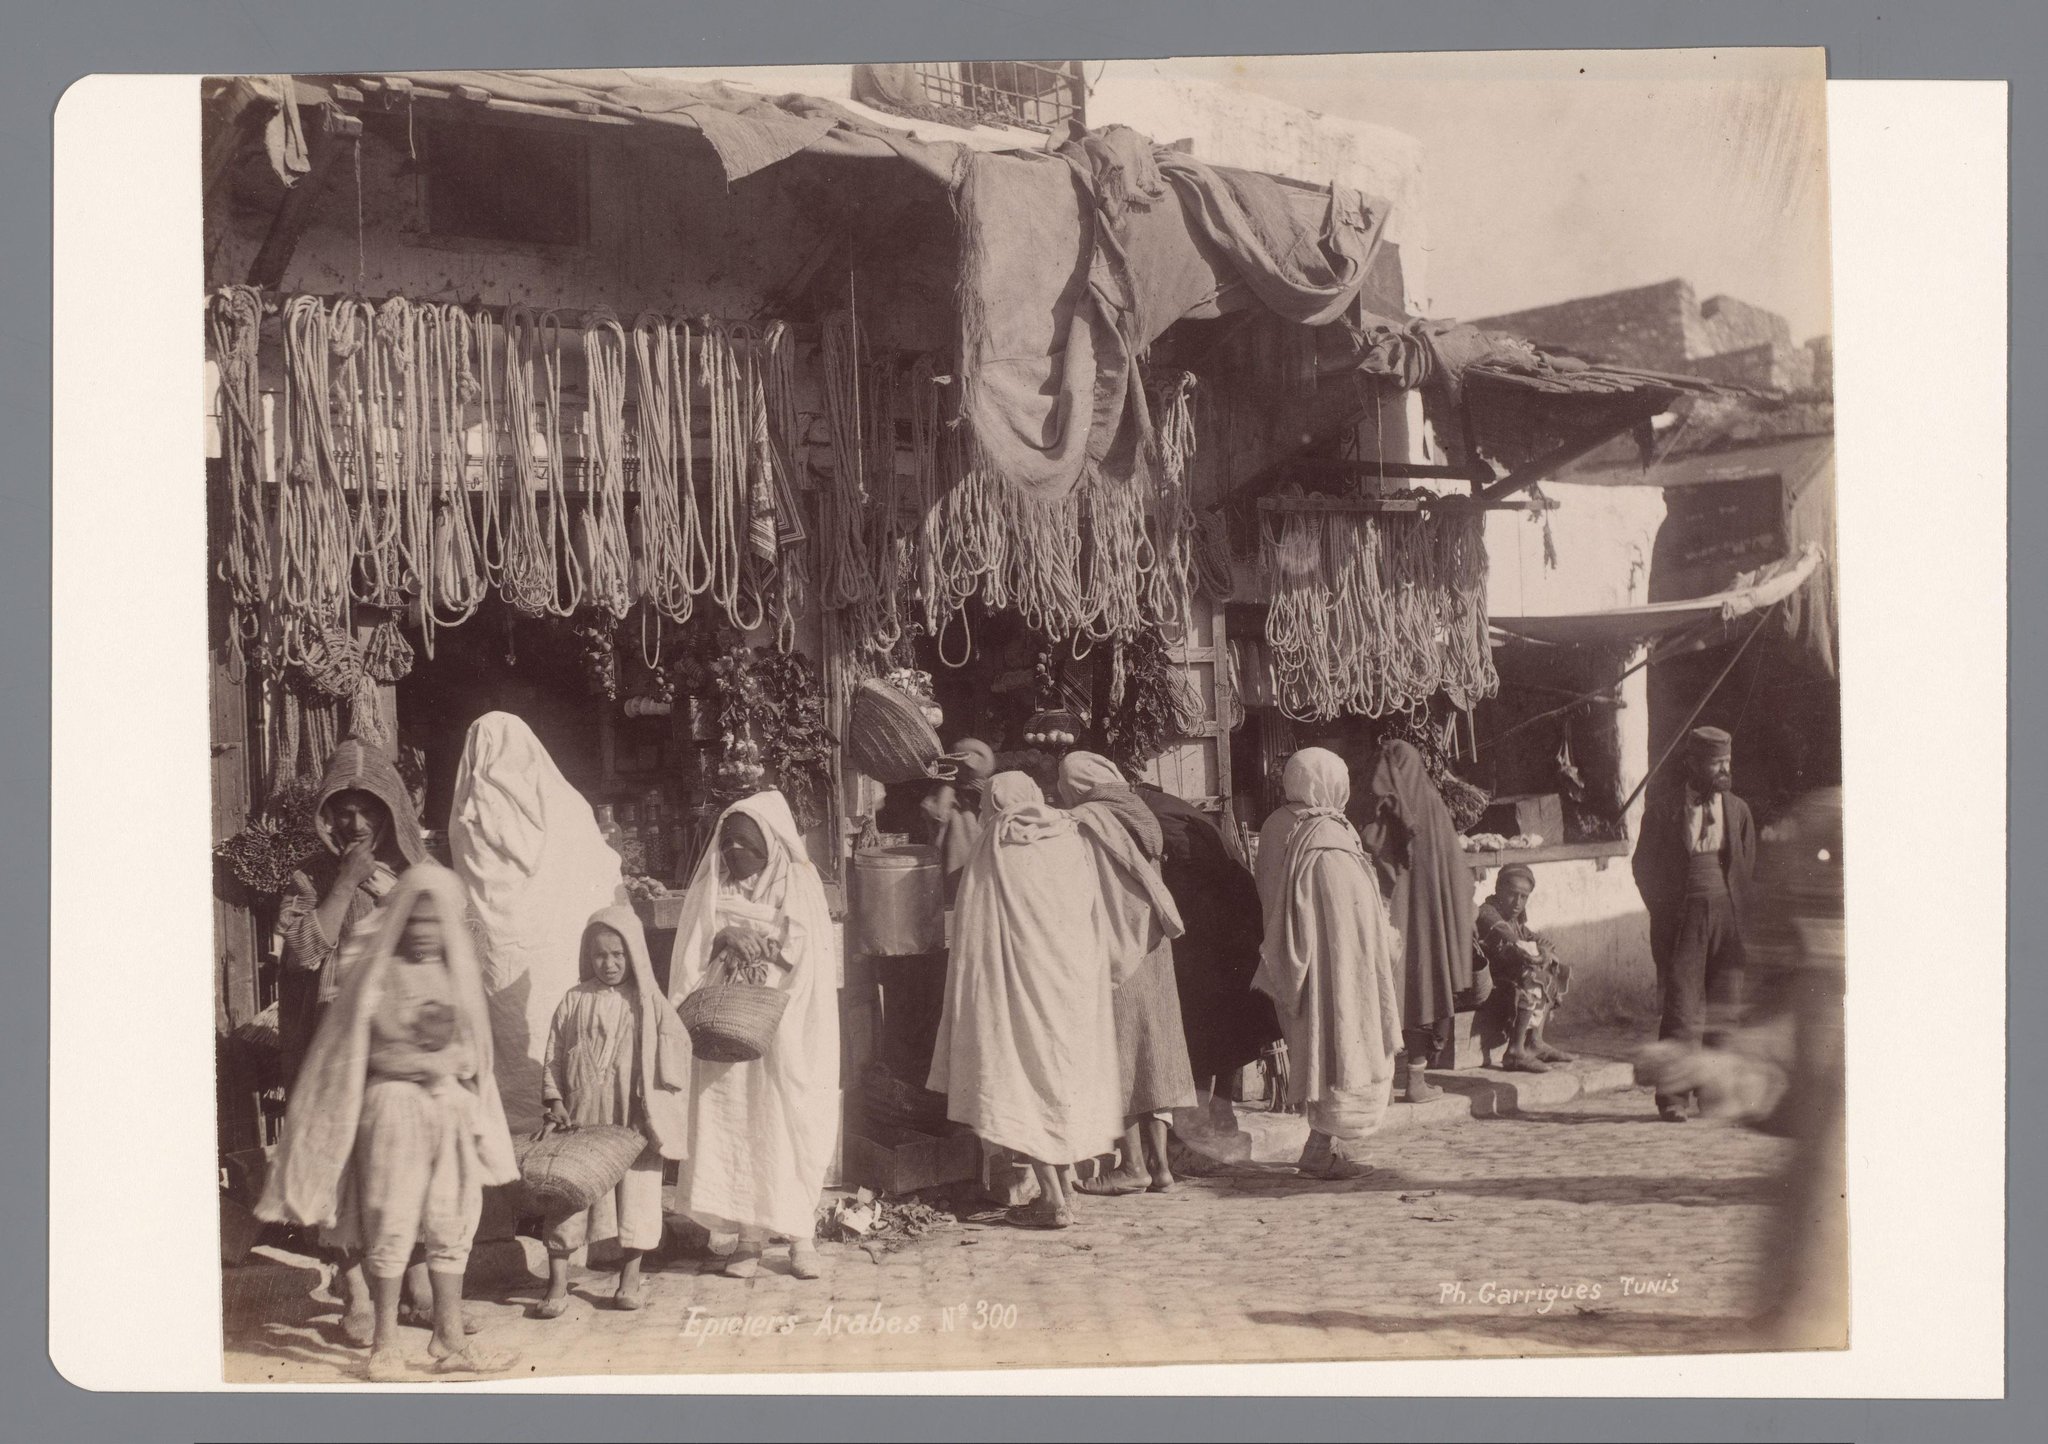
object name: photograph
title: Epiciers Arabes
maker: j. andré garrigues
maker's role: fotograaf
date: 1860-1900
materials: paper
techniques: albumen print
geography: tunis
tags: shop, store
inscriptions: number: ‘No 300’